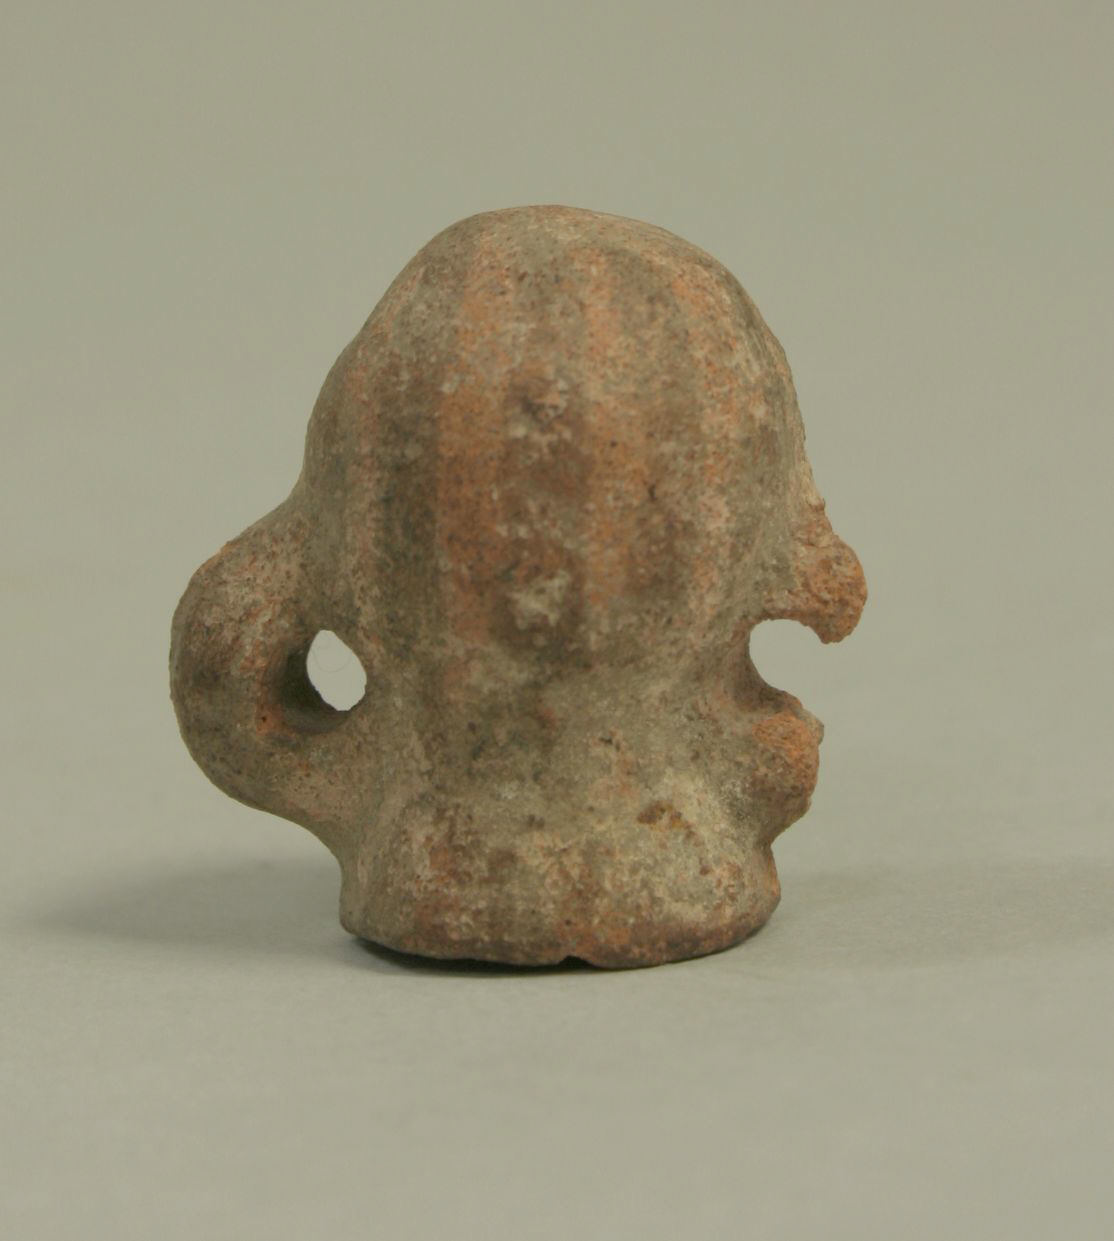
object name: jar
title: Miniature Jar with Handles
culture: peruvian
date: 300-1000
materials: ceramic, pigment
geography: peru